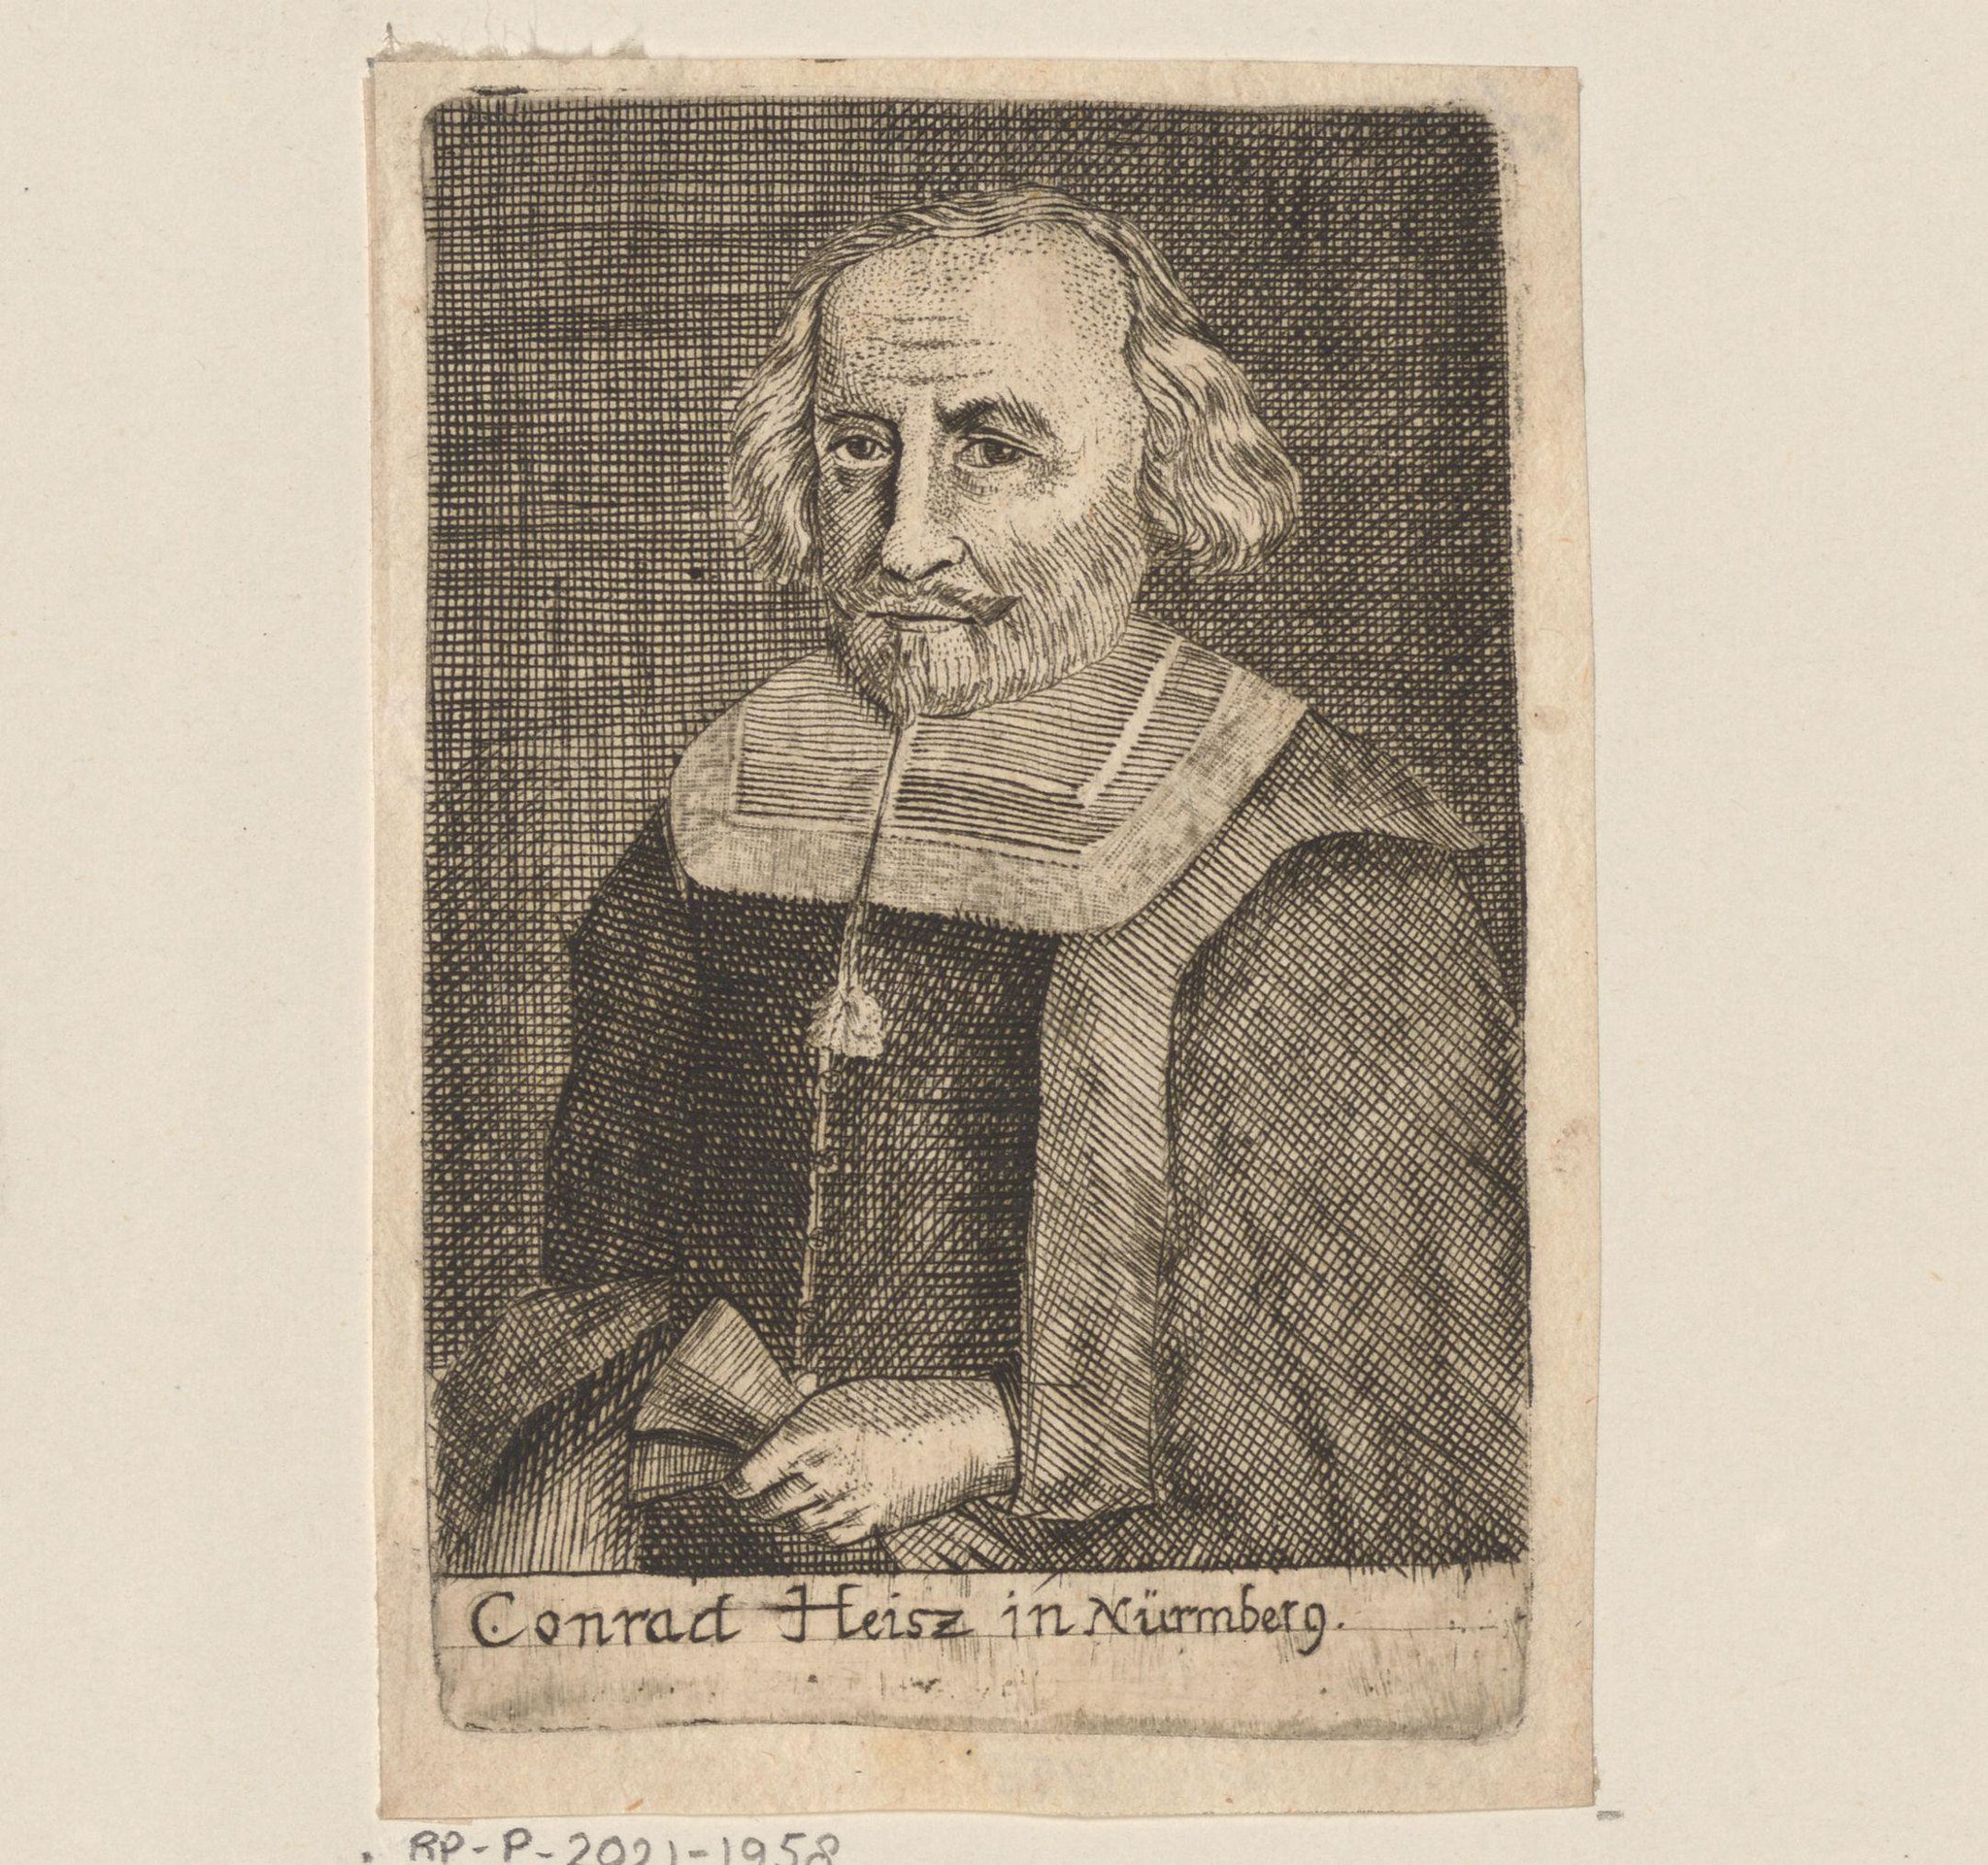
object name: print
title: Portret van Conrad Heiss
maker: Anonymous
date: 1650-1699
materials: paper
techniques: engraving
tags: historical persons